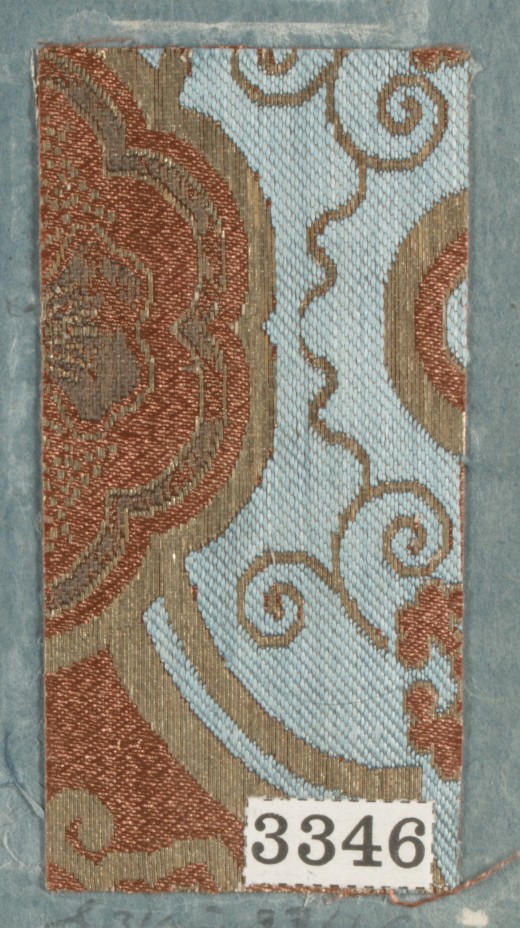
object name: sample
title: Textile Sample from Sample Book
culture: japanese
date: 1801-1900